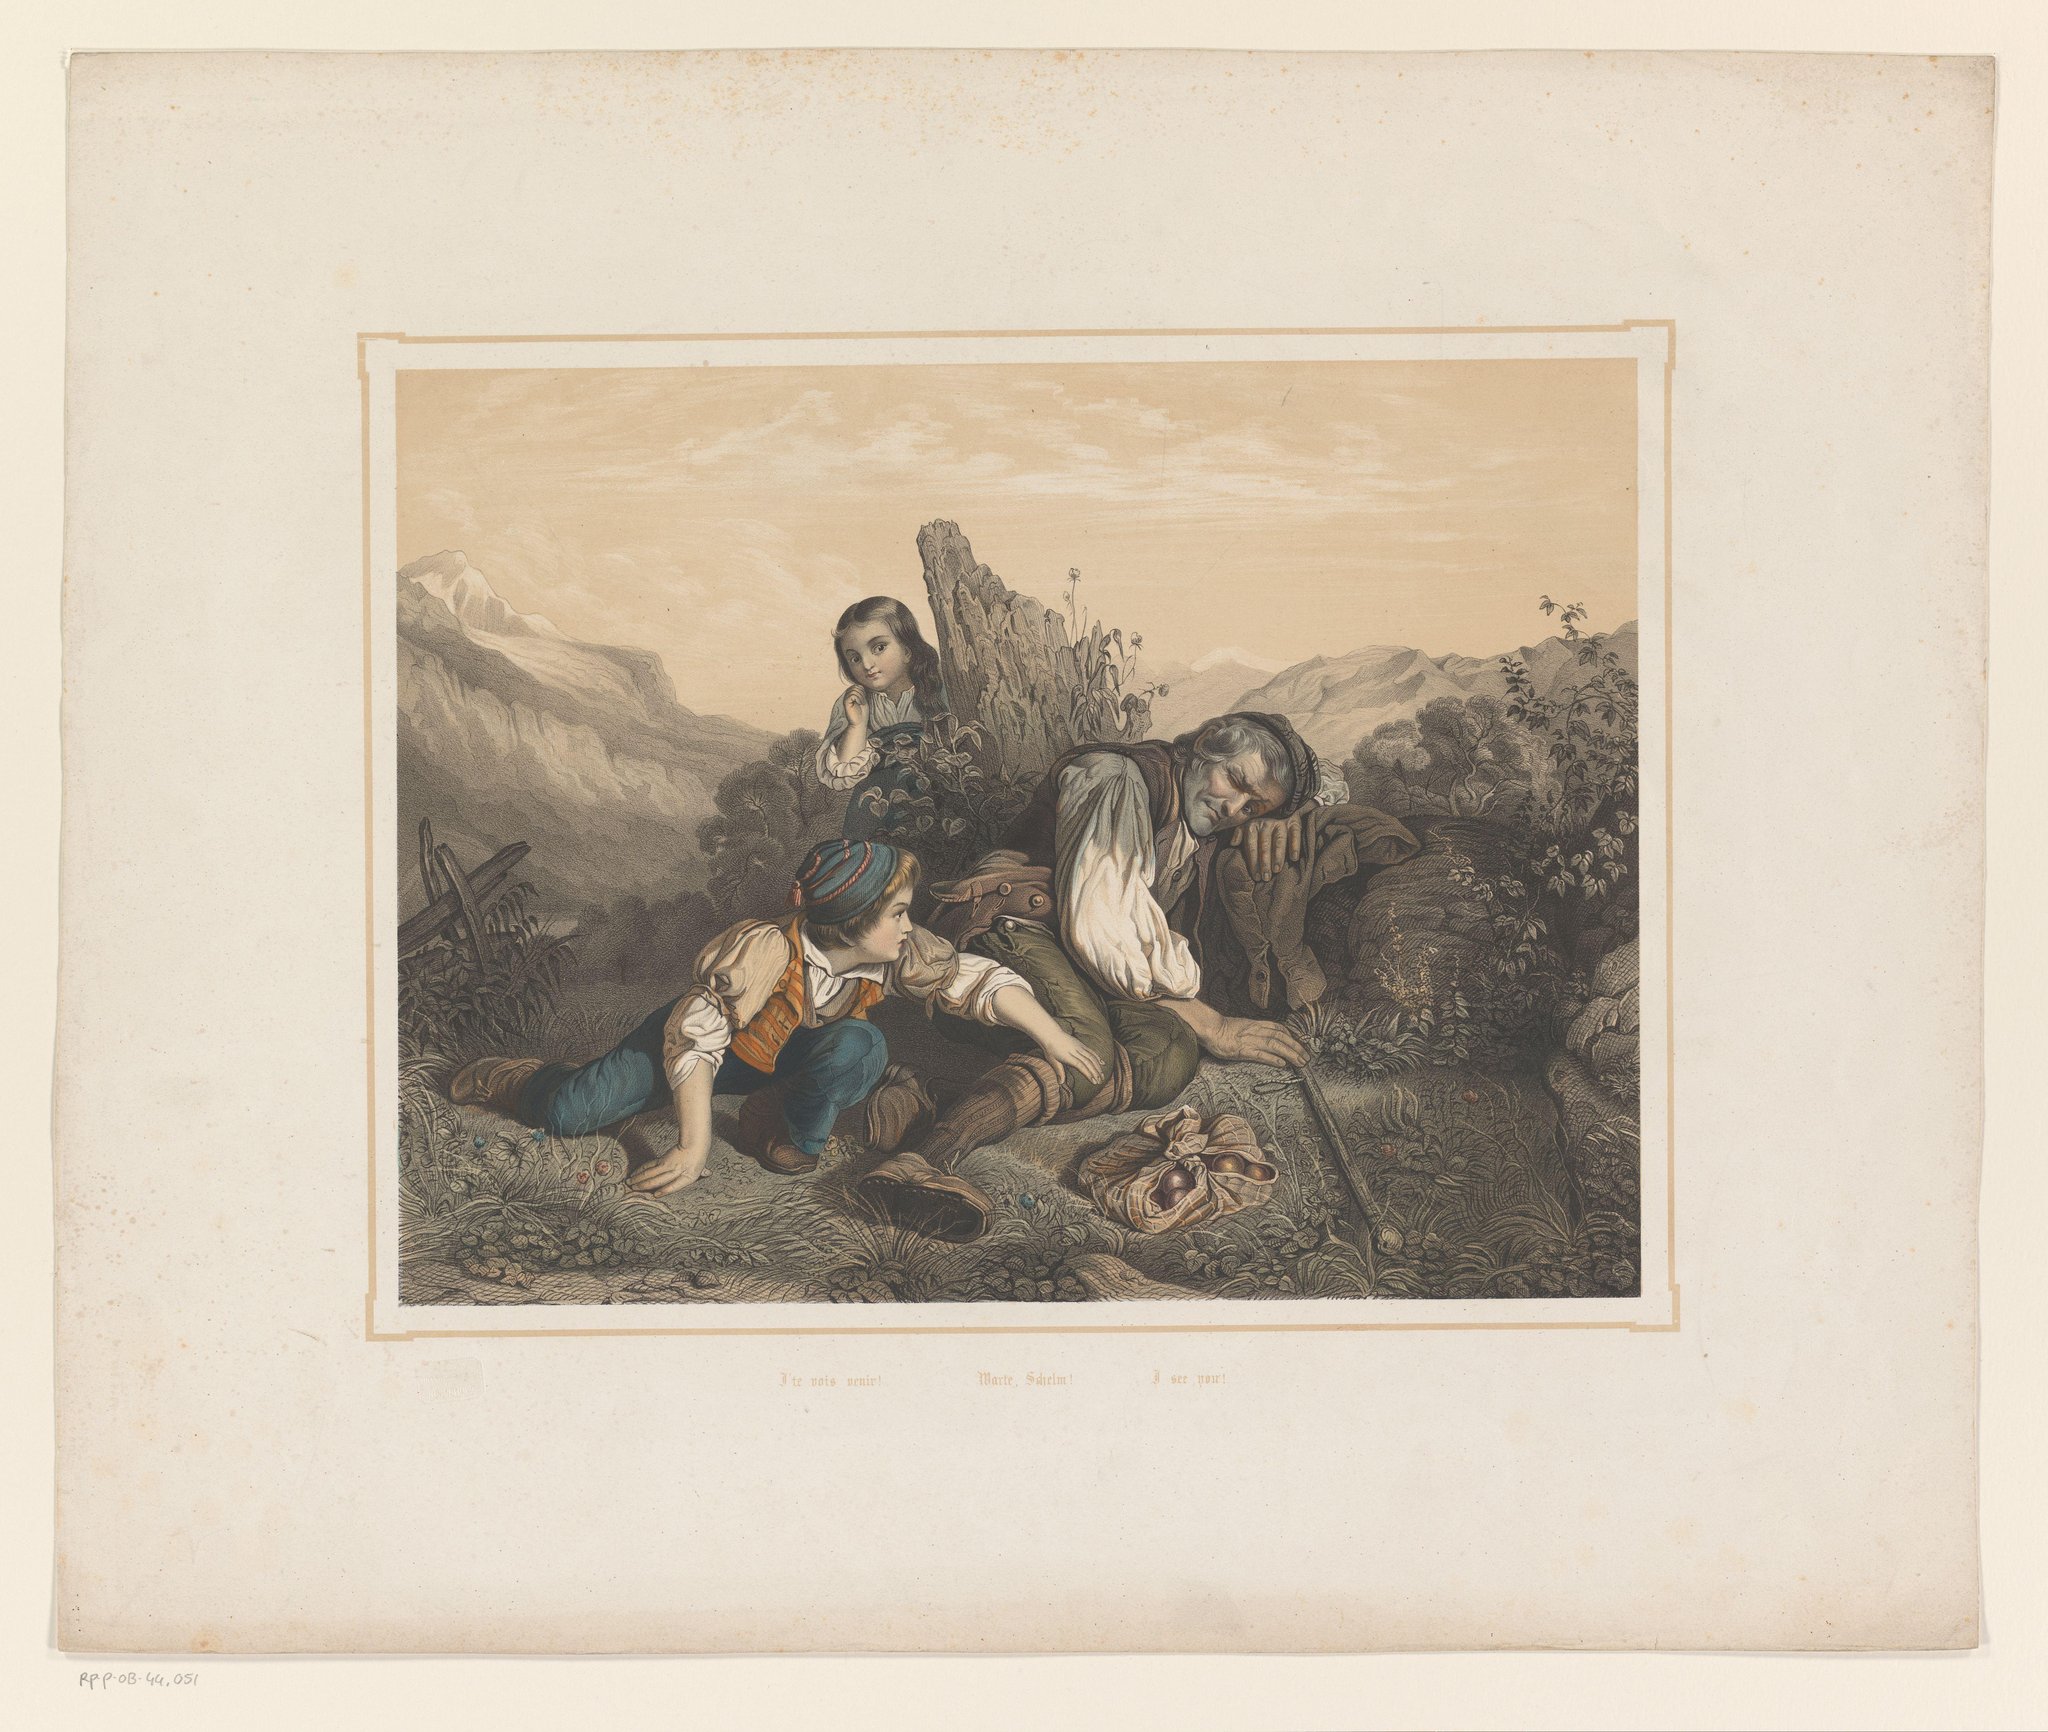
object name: print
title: Jongen probeert te stelen van een slapende man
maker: Anonymous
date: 1825-1875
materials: paper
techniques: hand coloring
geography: mainz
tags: sleeping on the ground - bb - out of doors, theft, child (+ two persons)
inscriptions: collector's mark: Lugt 2228, check stamp: ‘Mainz Druck&Verlag von Jos. Scholz’